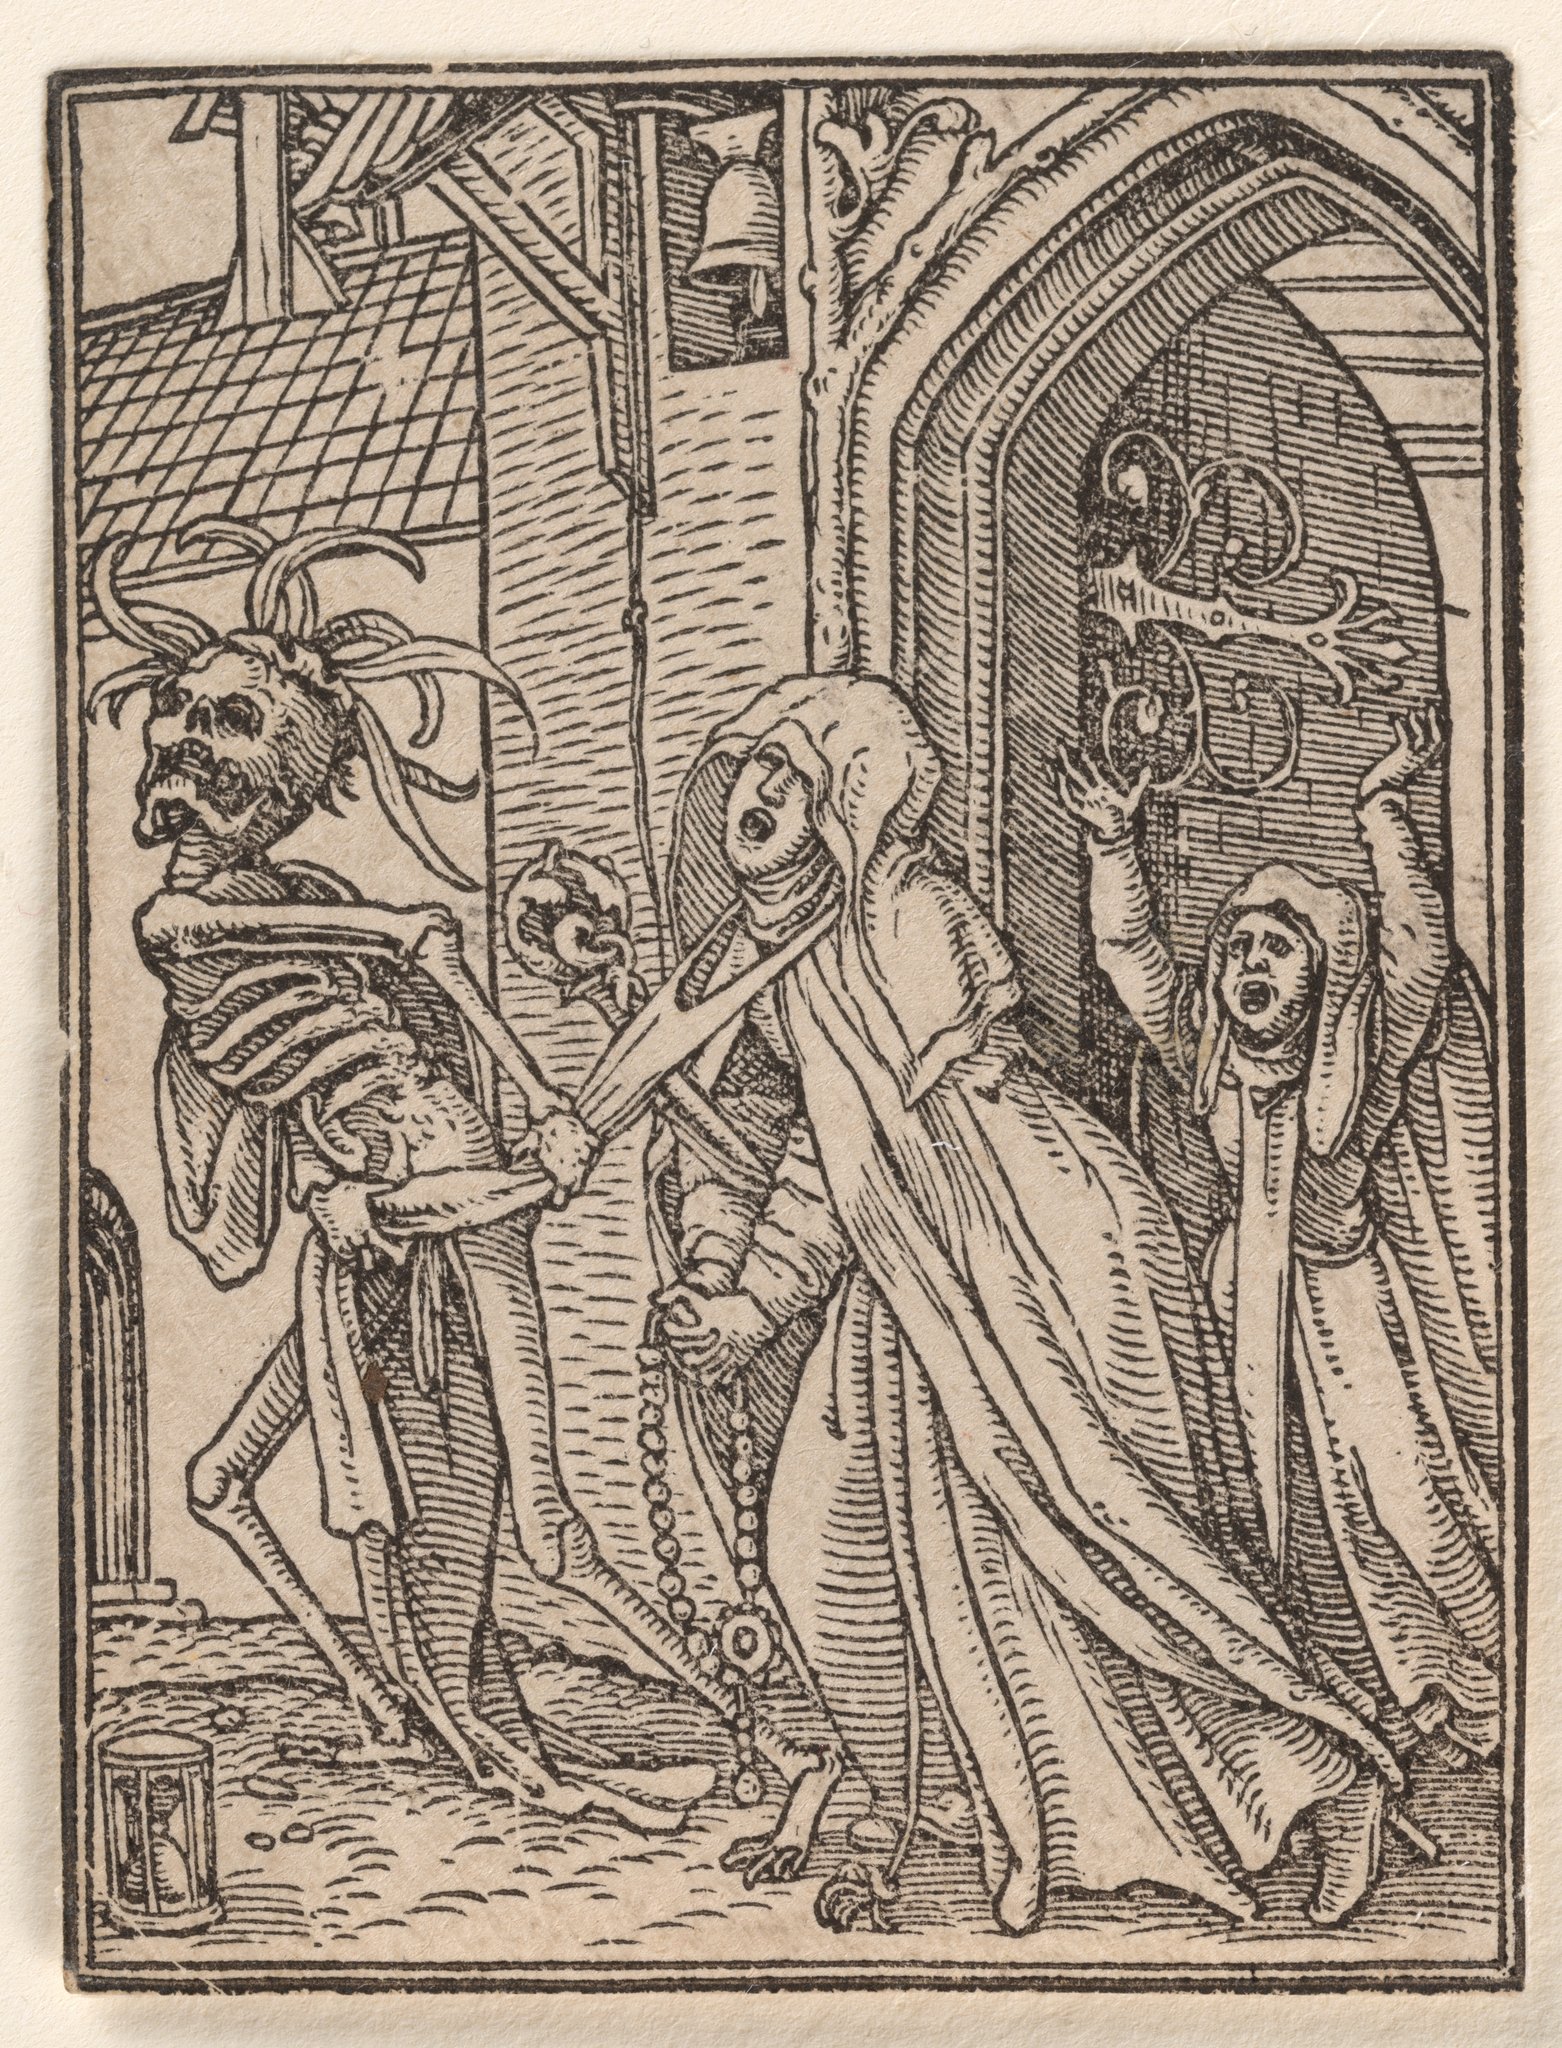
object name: print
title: The Abbess, from "The Dance of Death"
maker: hans holbein the younger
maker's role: artist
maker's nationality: german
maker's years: 1497-1543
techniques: woodcut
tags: skeletons,women